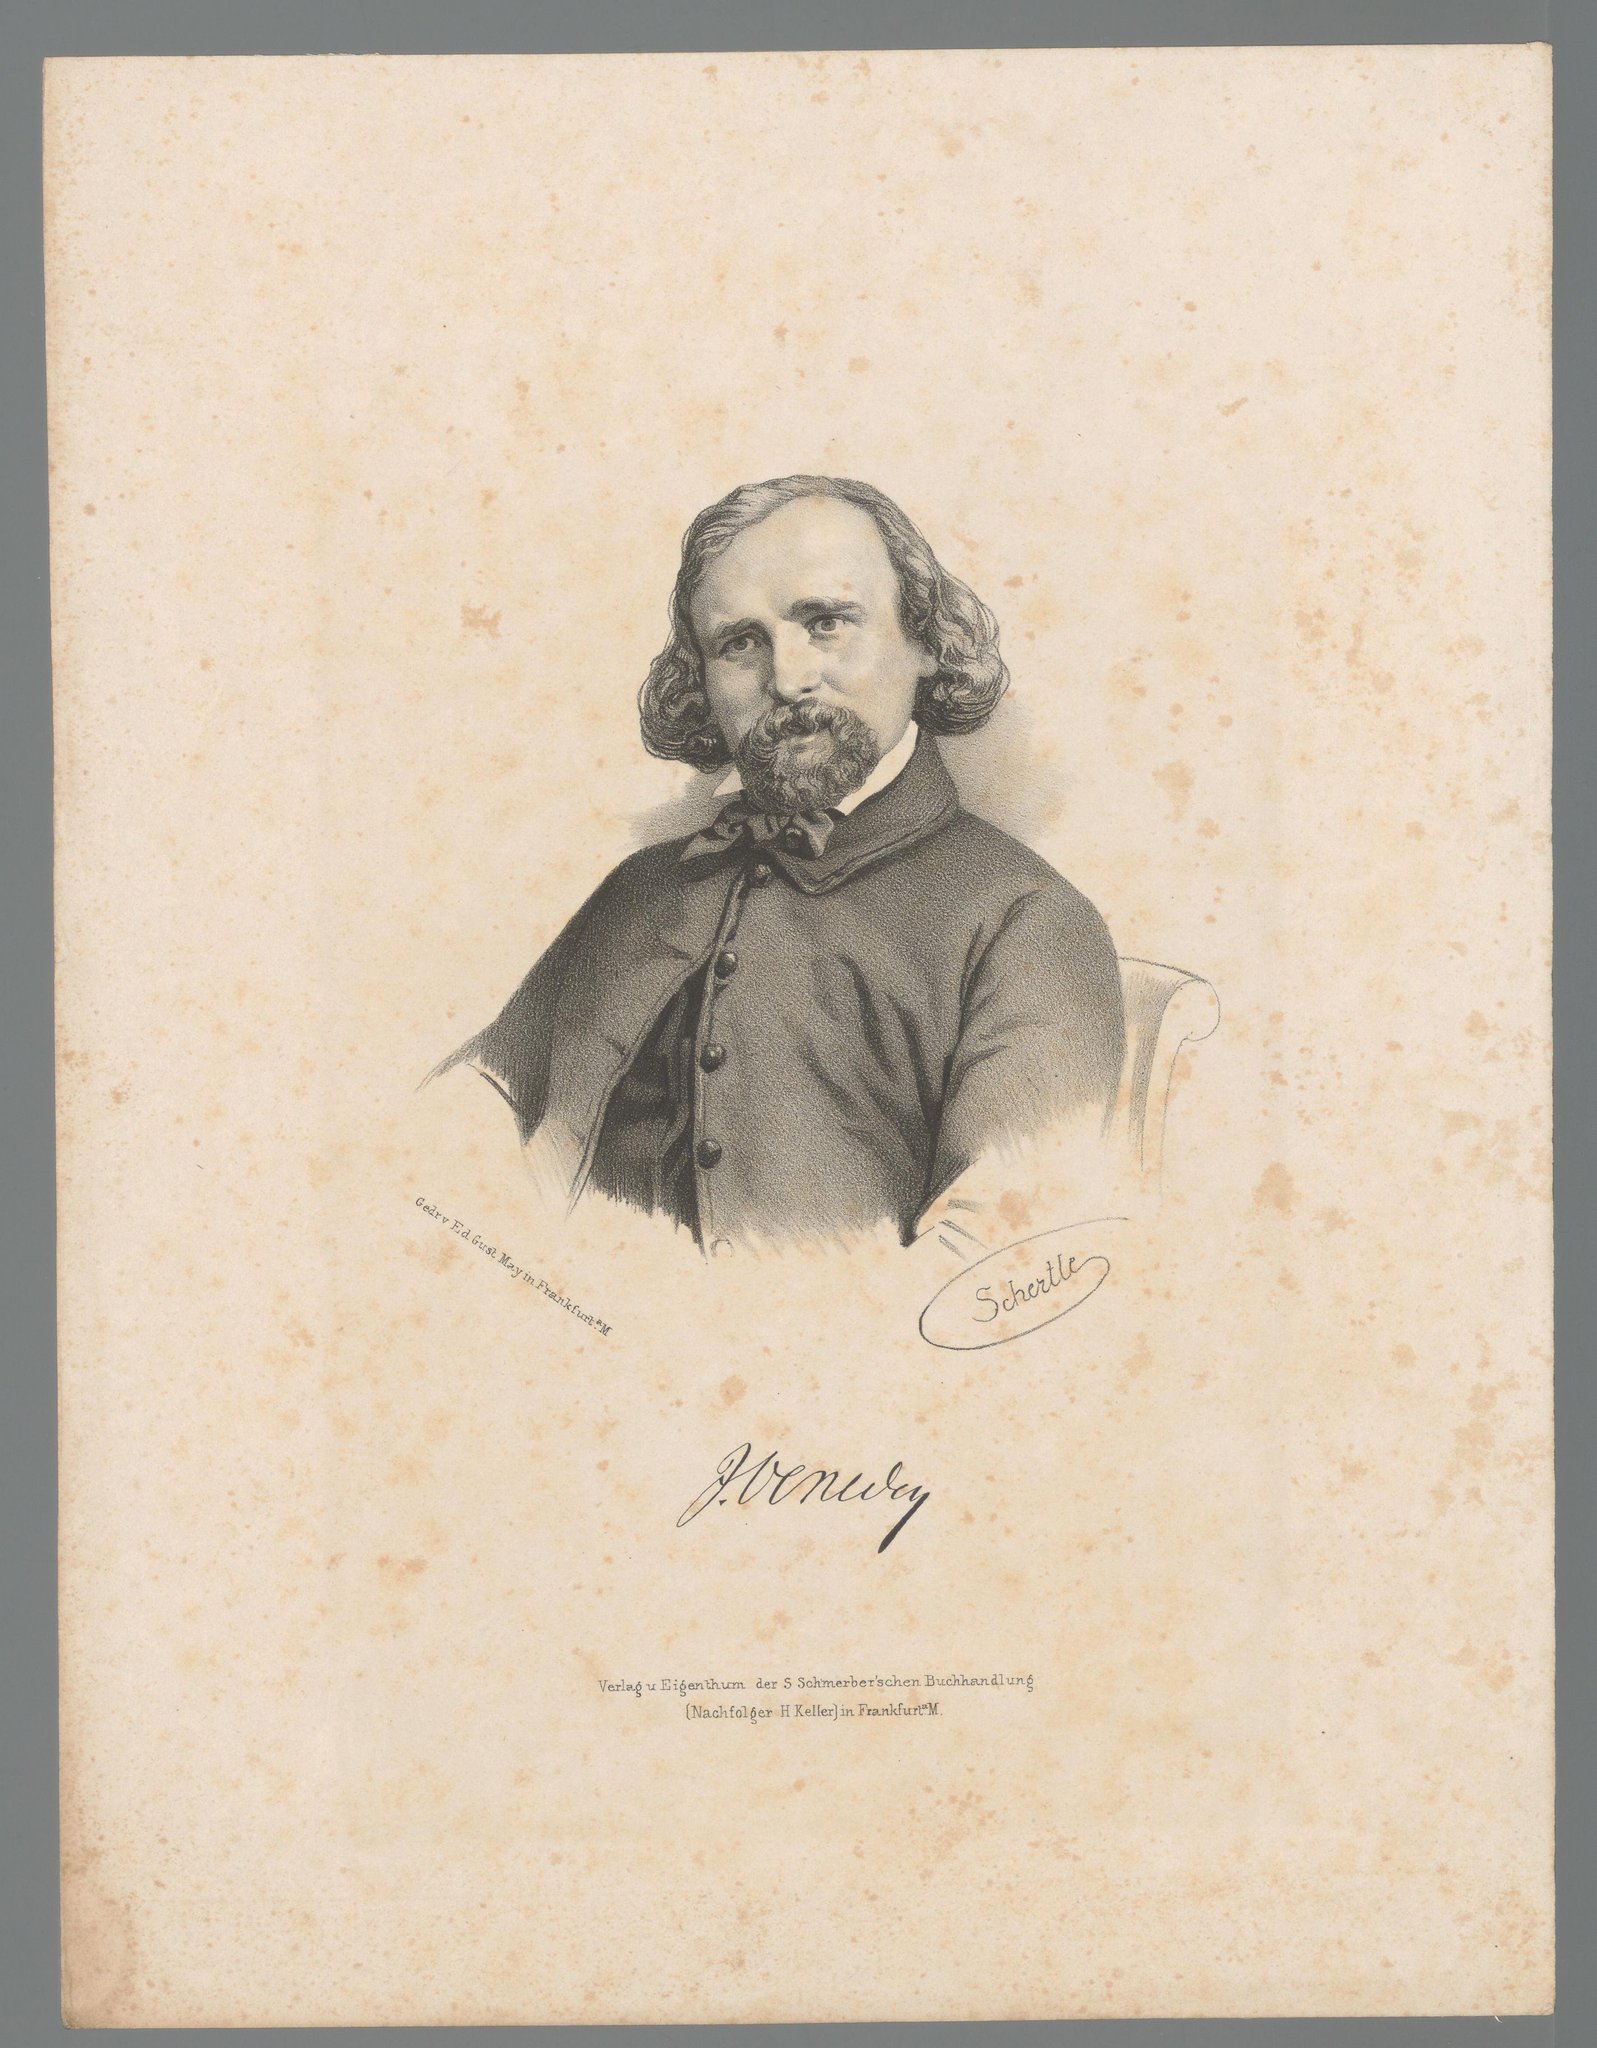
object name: print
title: Portret van Jakob Venedey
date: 1848-1849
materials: paper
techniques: lithograph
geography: frankfurt am main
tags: cologne, politician, adult man, historical persons, beard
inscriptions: collector's mark: Lugt 2228